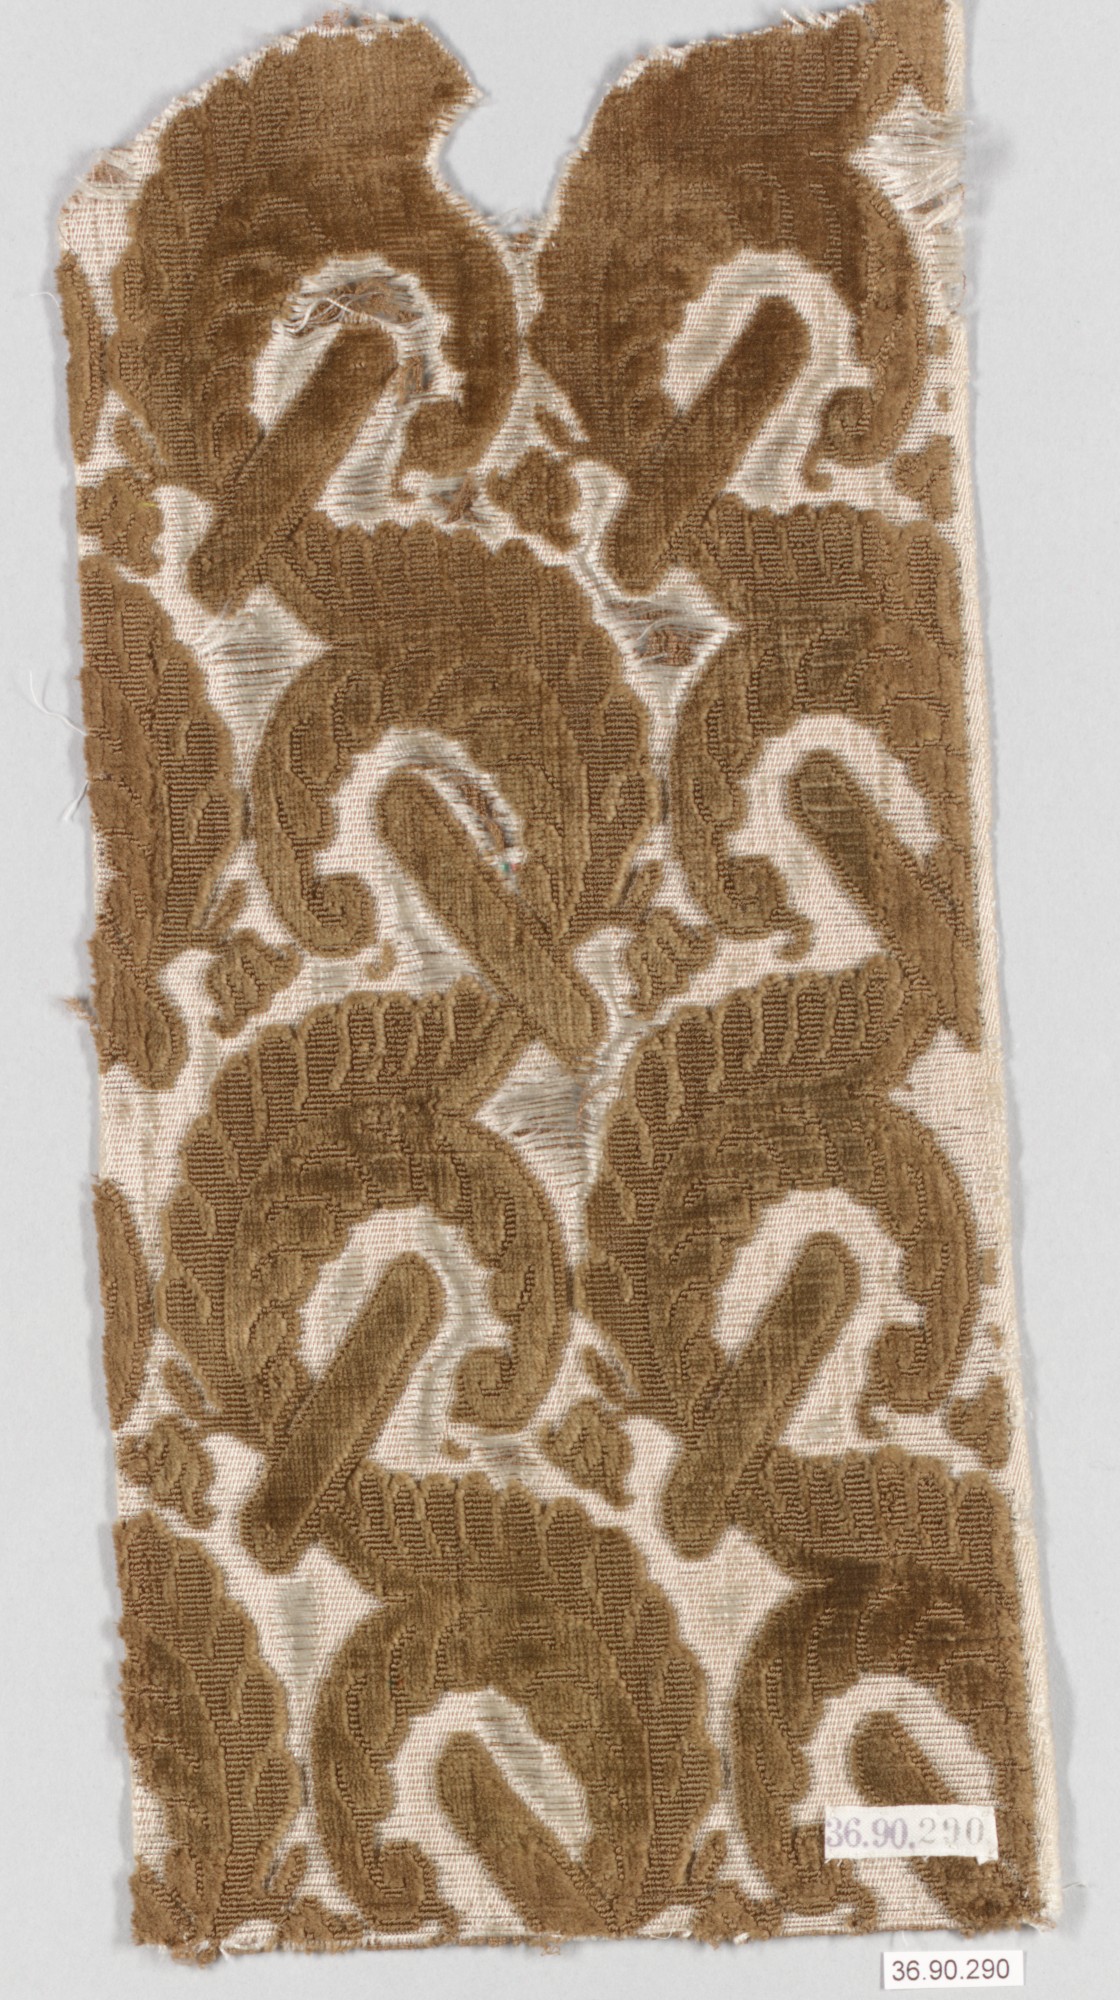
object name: piece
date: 1501-1700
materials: metal thread, silk